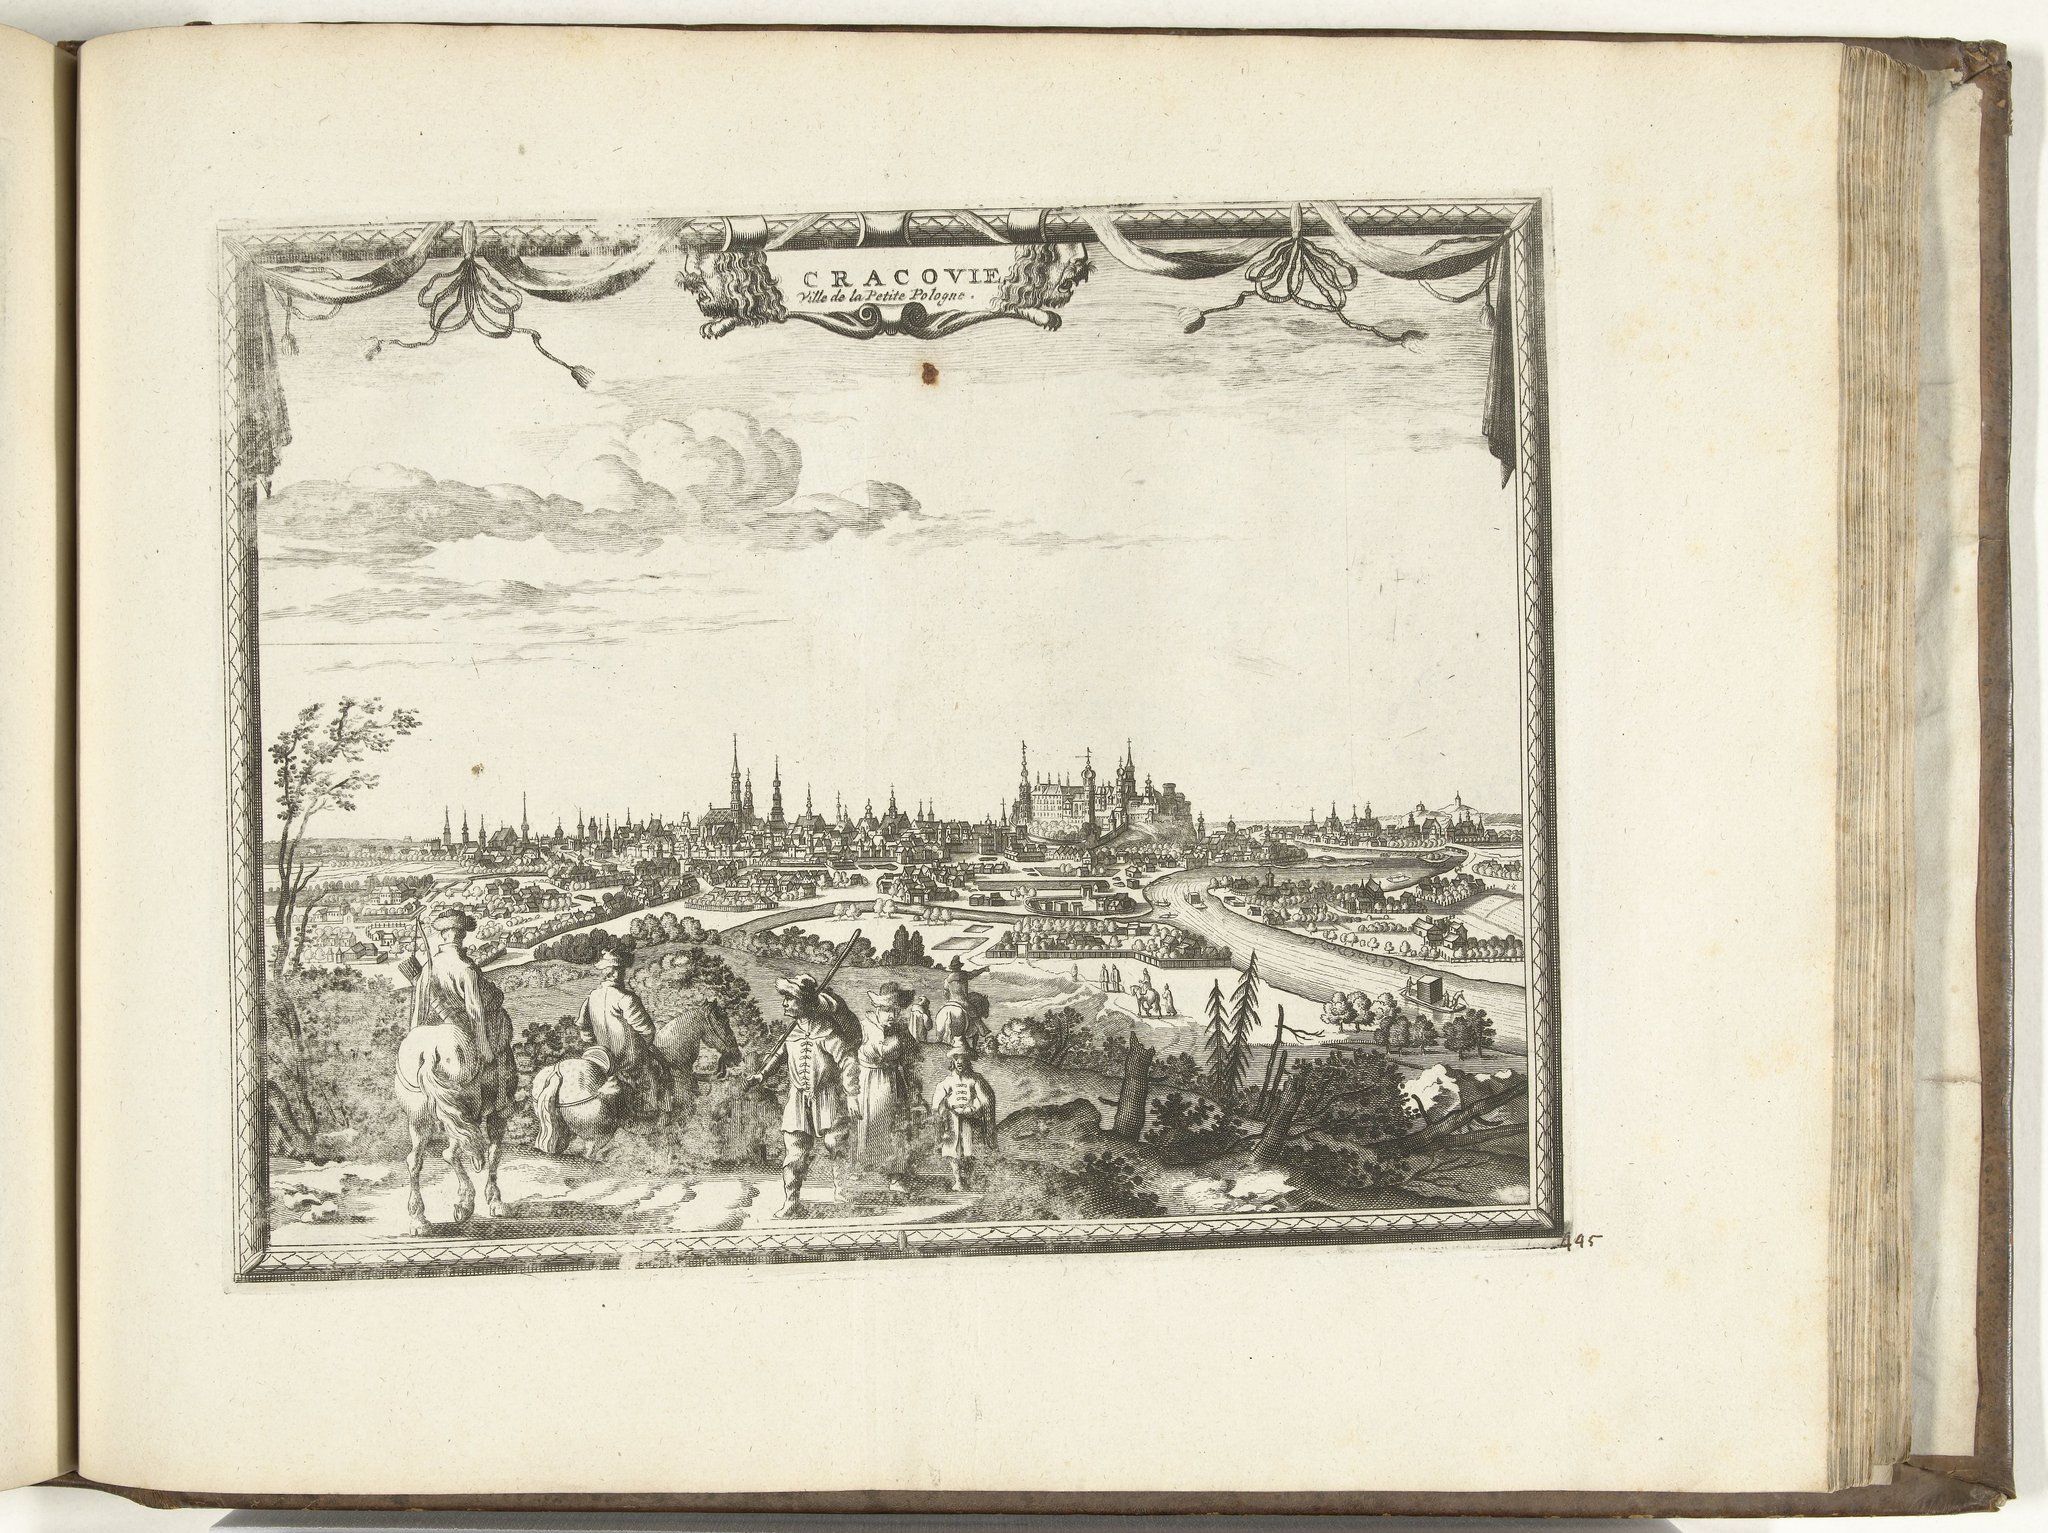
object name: print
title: Les Forces de l'Europe, Asie, Afrique et Amerique (...) Comme aussi les Cartes des Côtes de France et d'Espagne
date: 1726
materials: paper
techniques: etching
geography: leiden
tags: krakau, spaanse successieoorlog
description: Gezicht op Krakau, op de voorgrond ruiters en wandelaars op een weg. Plaat nr. 445 in deel XVIII van het prentwerk: Les Forces de l'Europe, Asie, Afrique et Amerique ... Comme aussi les Cartes des Côtes de France et d'Espagne uit 1726, dit tweede deel met 271 met de hand genummerde platen van vermaarde sterke steden en vestingen in het kader van de Spaanse Successieoorlog 1701-1713. Voor het merendeel zijn deze platen gekopieerd naar de anonieme Franse platen van vermaarde sterke steden en vestingen: in Les forces de l'Europe en in: Le theatre de la guerre, dans les Pays-Bas, beide oorspronkelijk uitgegeven door Nicolas de Fer te Parijs (1693-1697) in het kader van de Negenjarige Oorlog. Titel in het Frans.